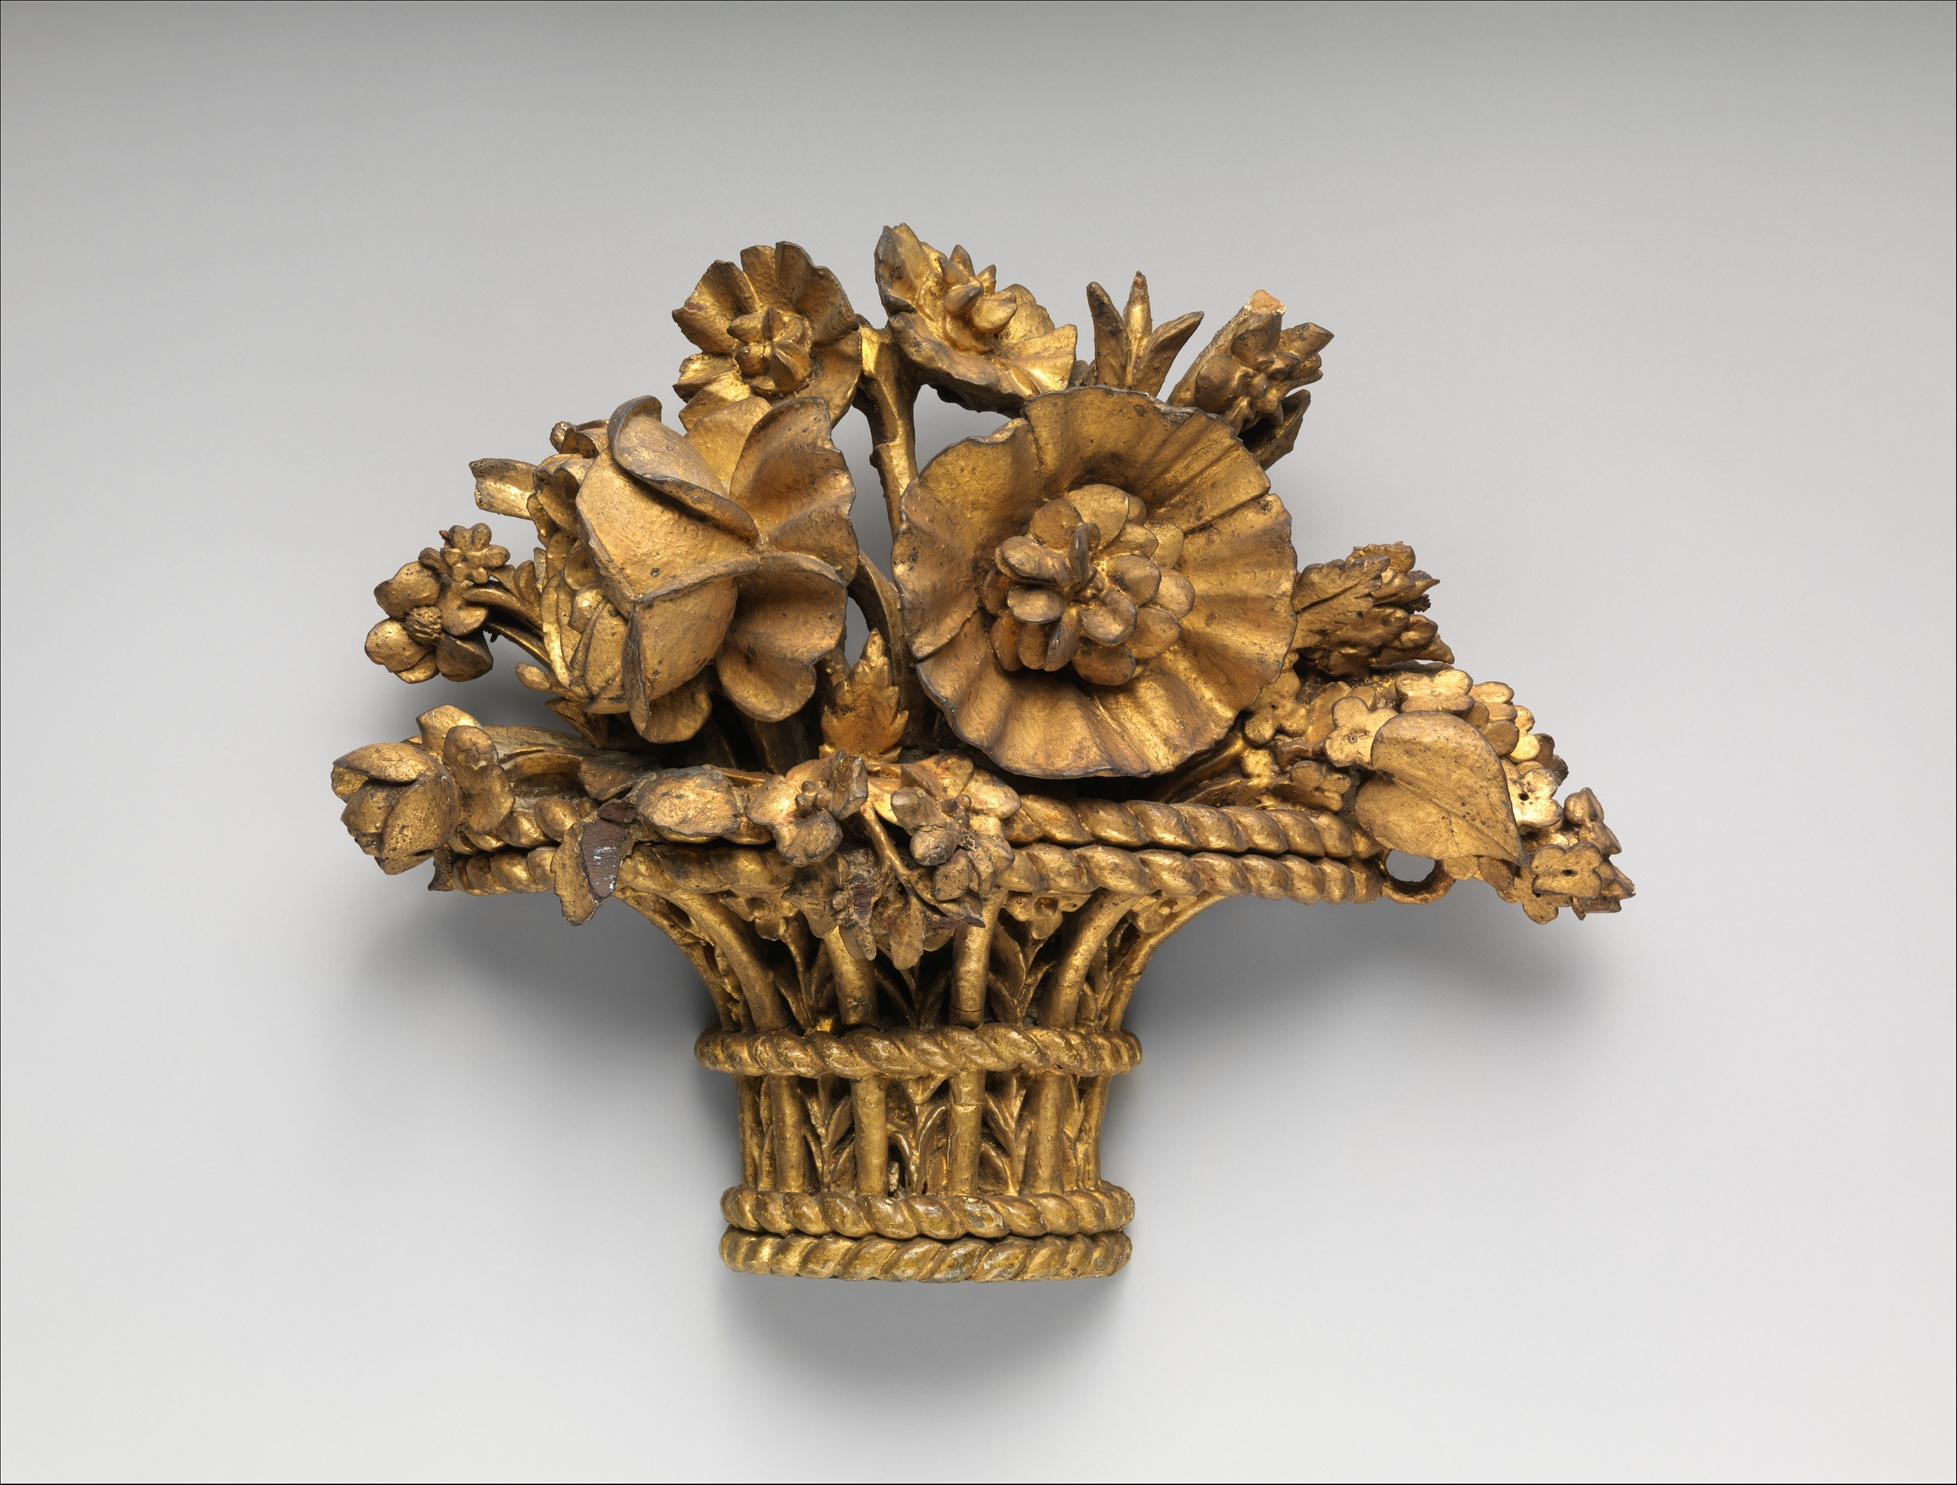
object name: carving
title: Basket of flowers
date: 1701-1800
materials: wood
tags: flowers